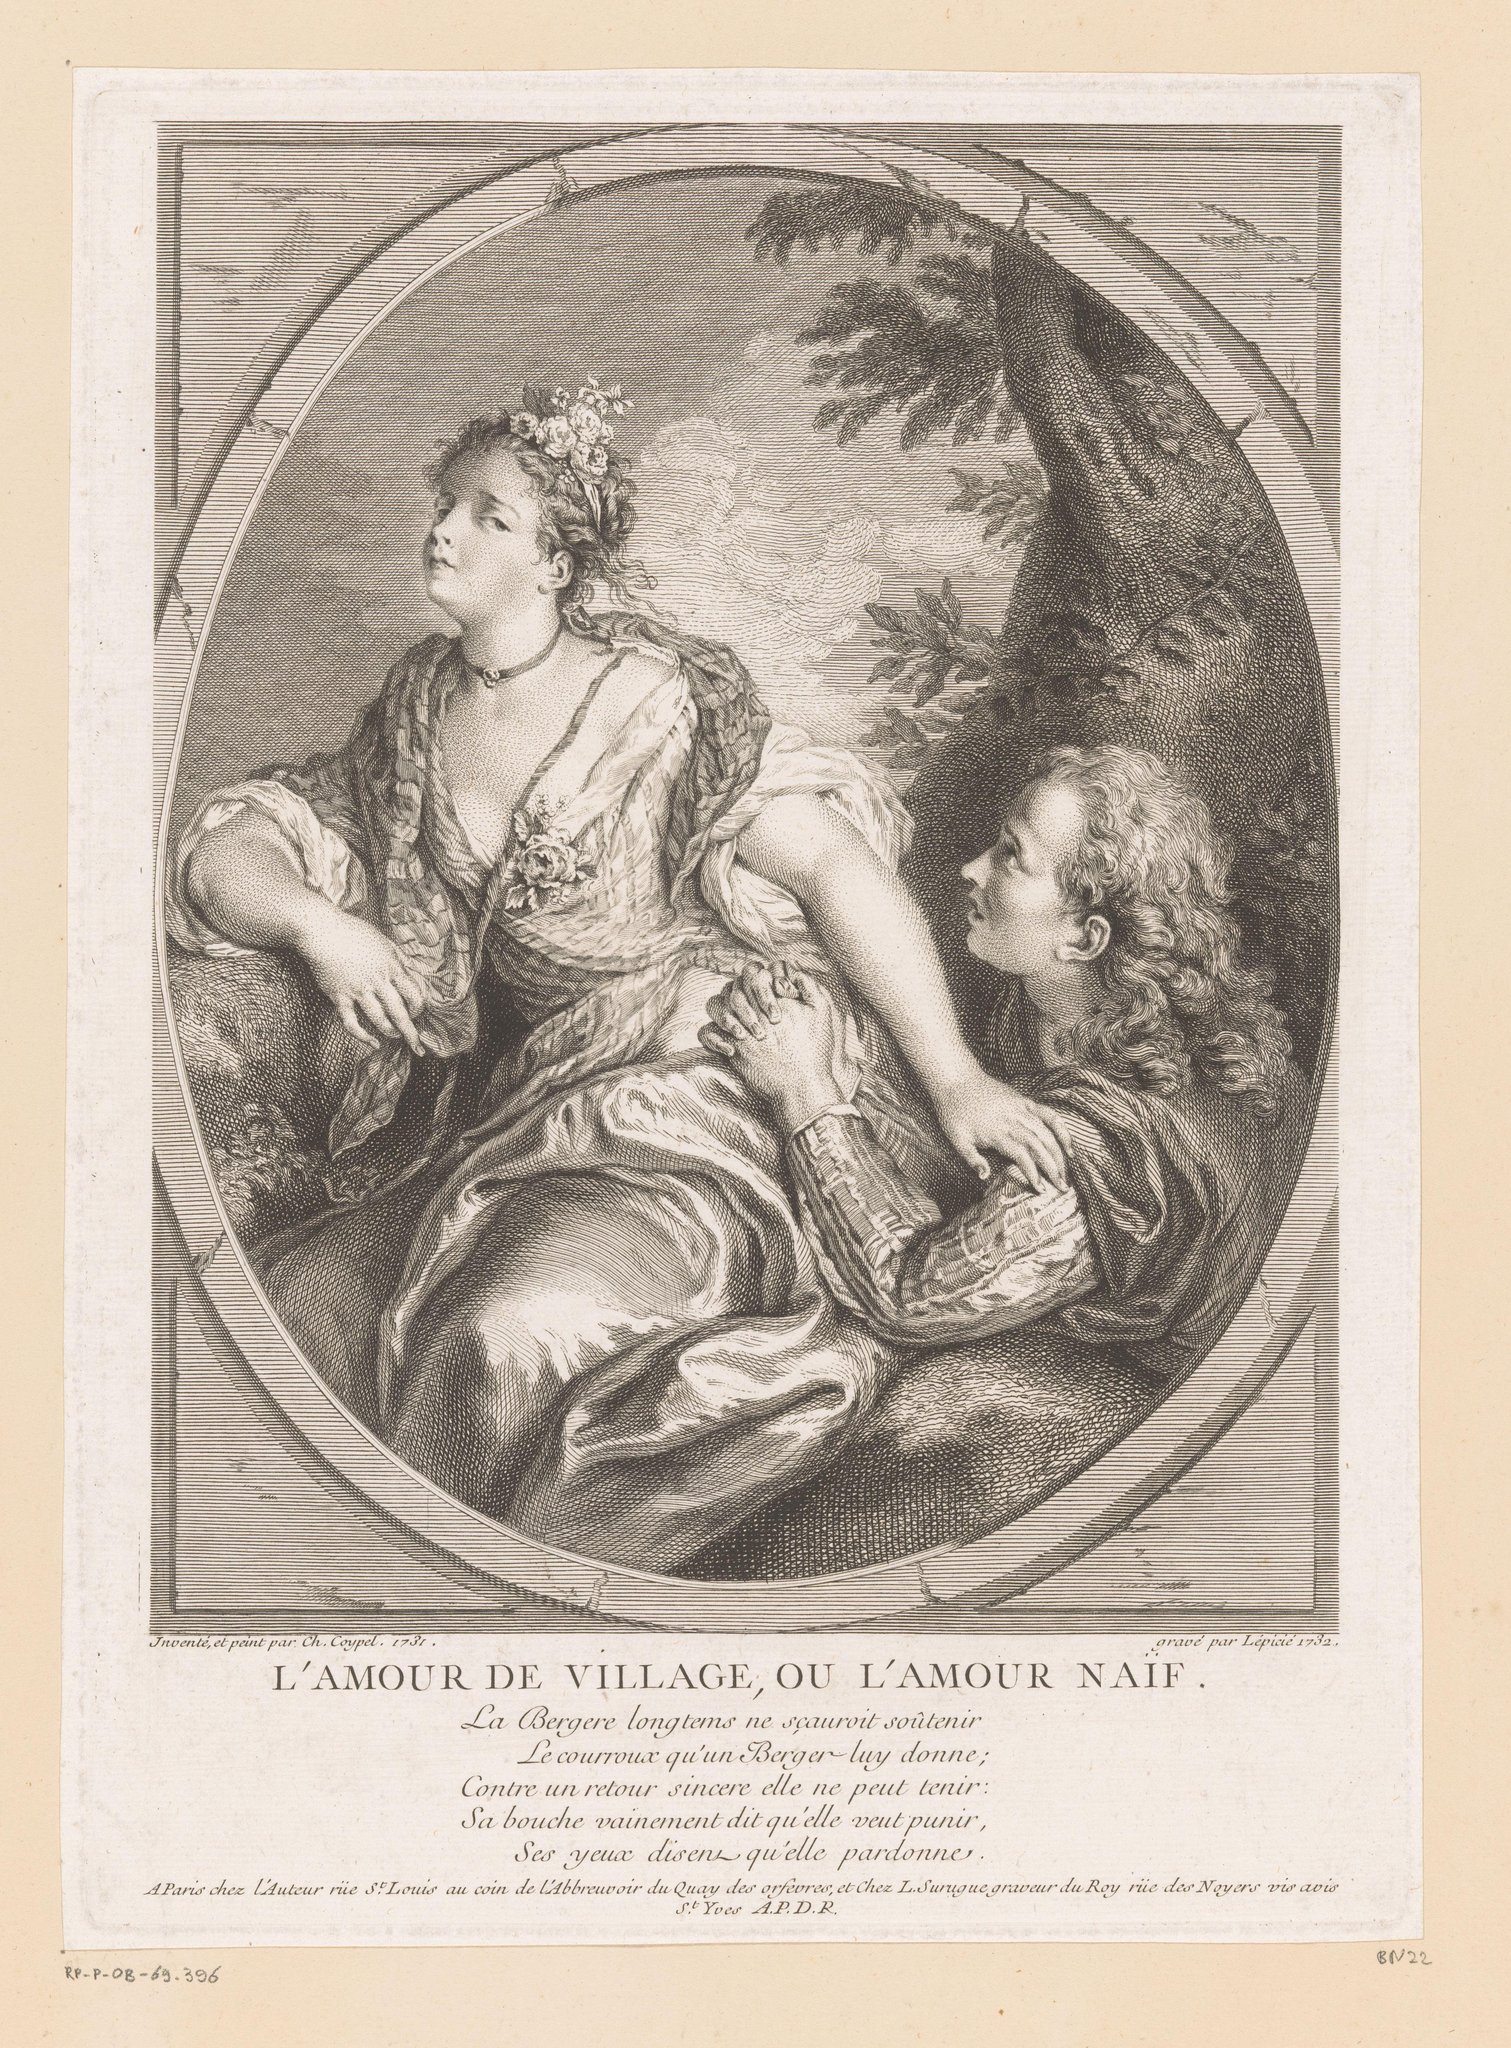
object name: print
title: Jonge man smeekt bij een jonge vrouw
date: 1732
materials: paper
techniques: engraving, etching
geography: france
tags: pleading, rejection, being refused, the proposal rejected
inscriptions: collector's mark: Lugt 240